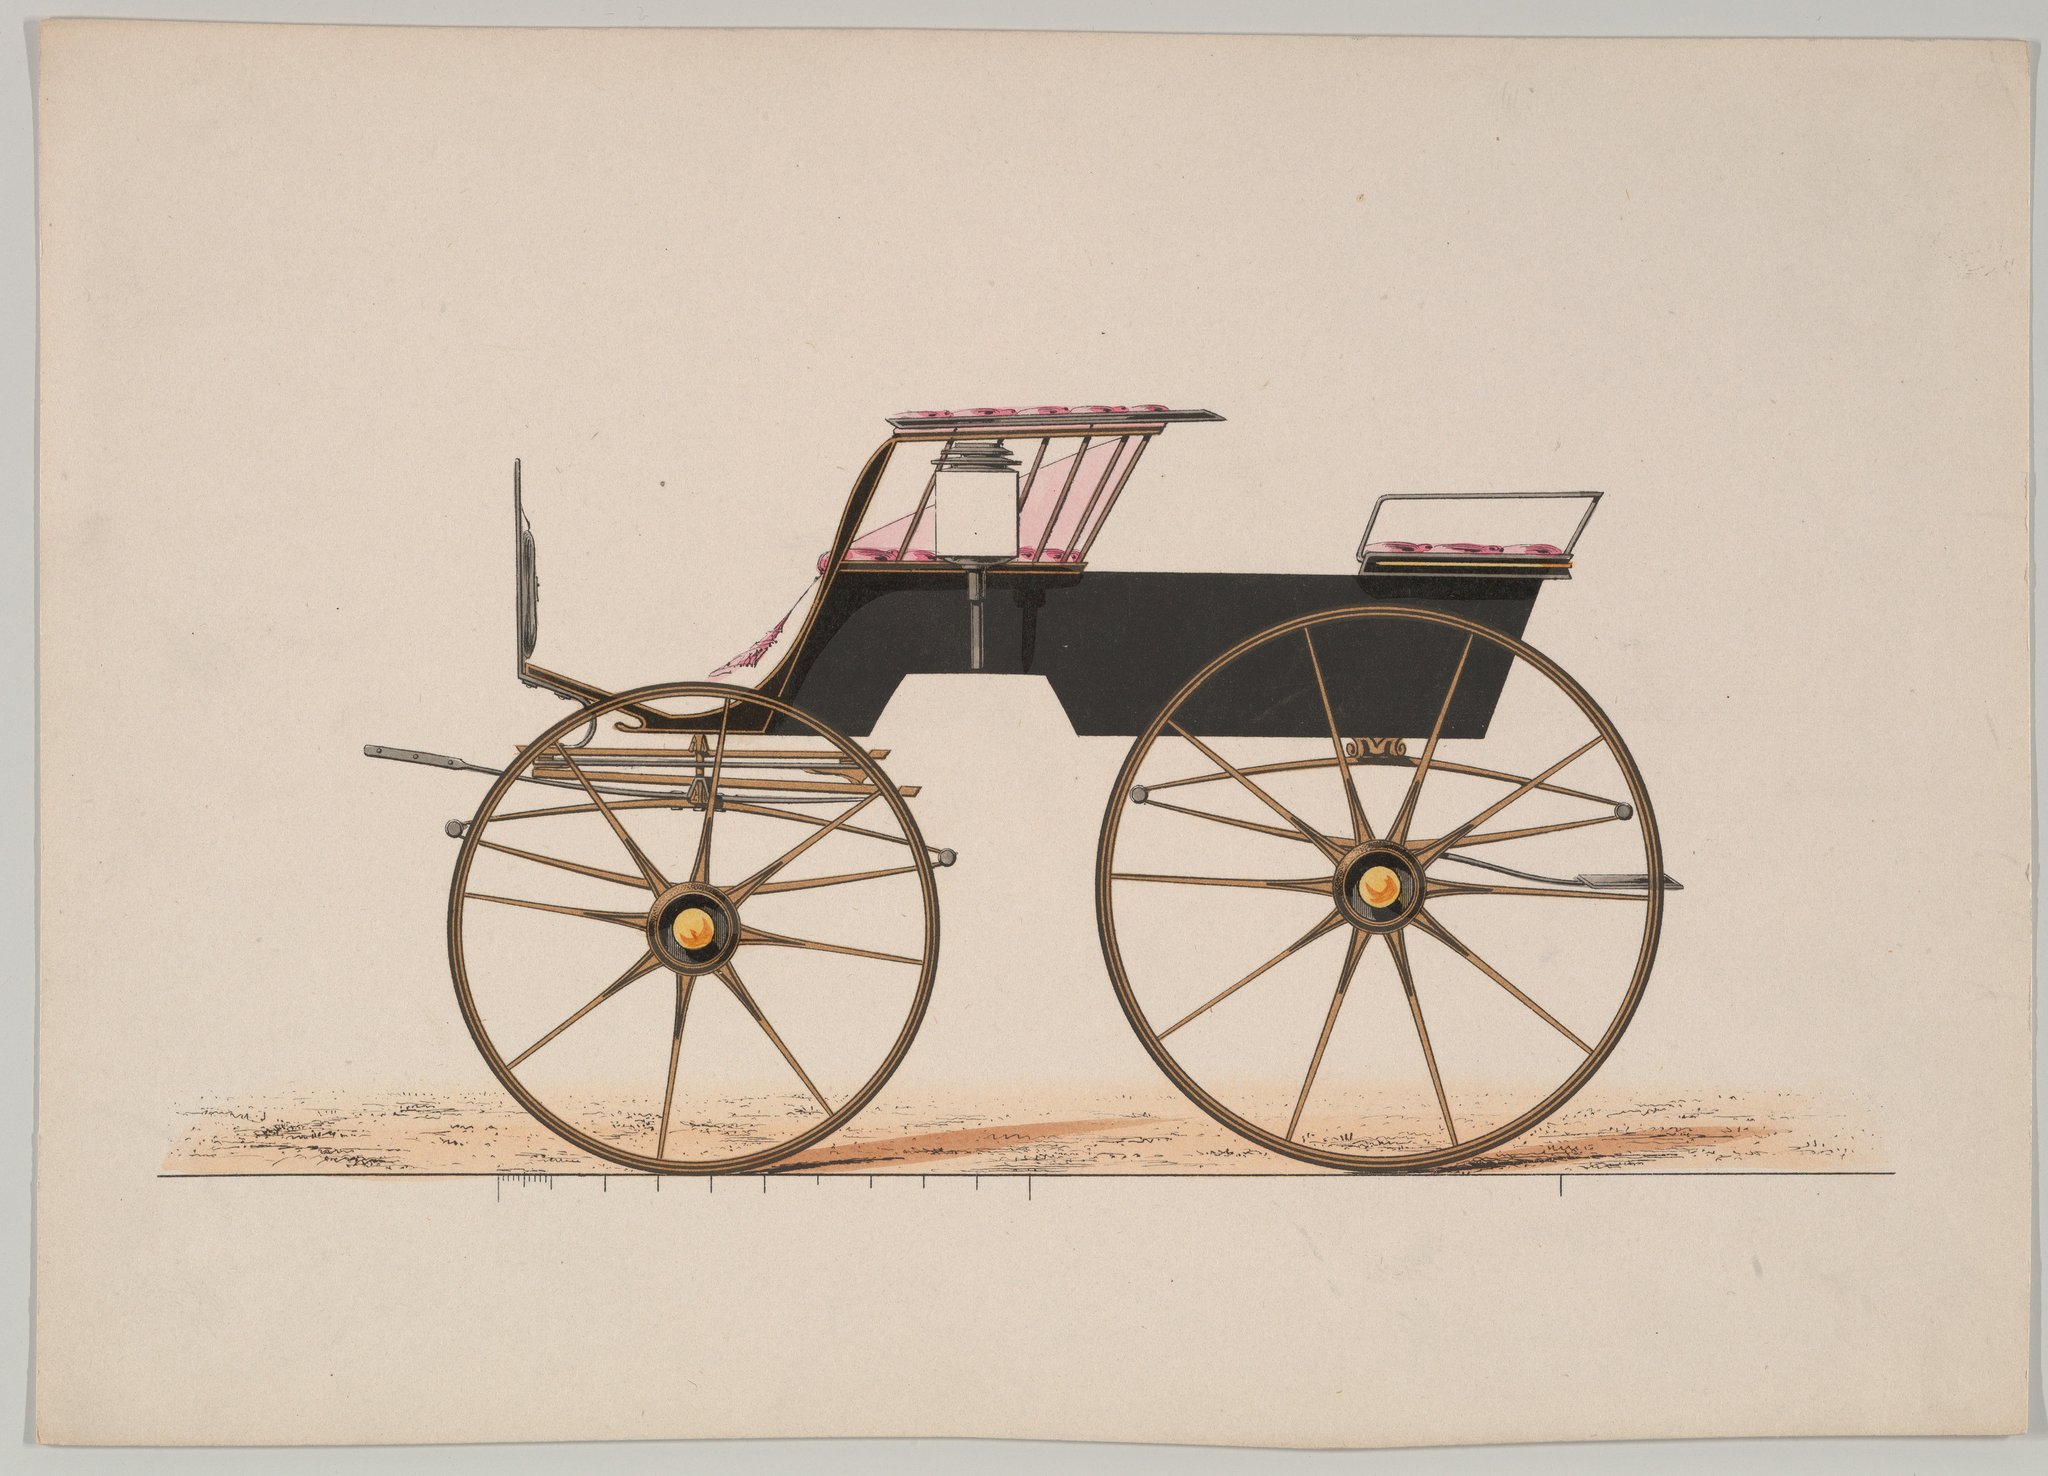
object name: drawing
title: T-Cart Phaeton (unnumbered)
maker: brewster & co.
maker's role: manufacturer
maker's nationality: american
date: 1850-1870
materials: gum arabic, ink, watercolor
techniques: pen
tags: carriages